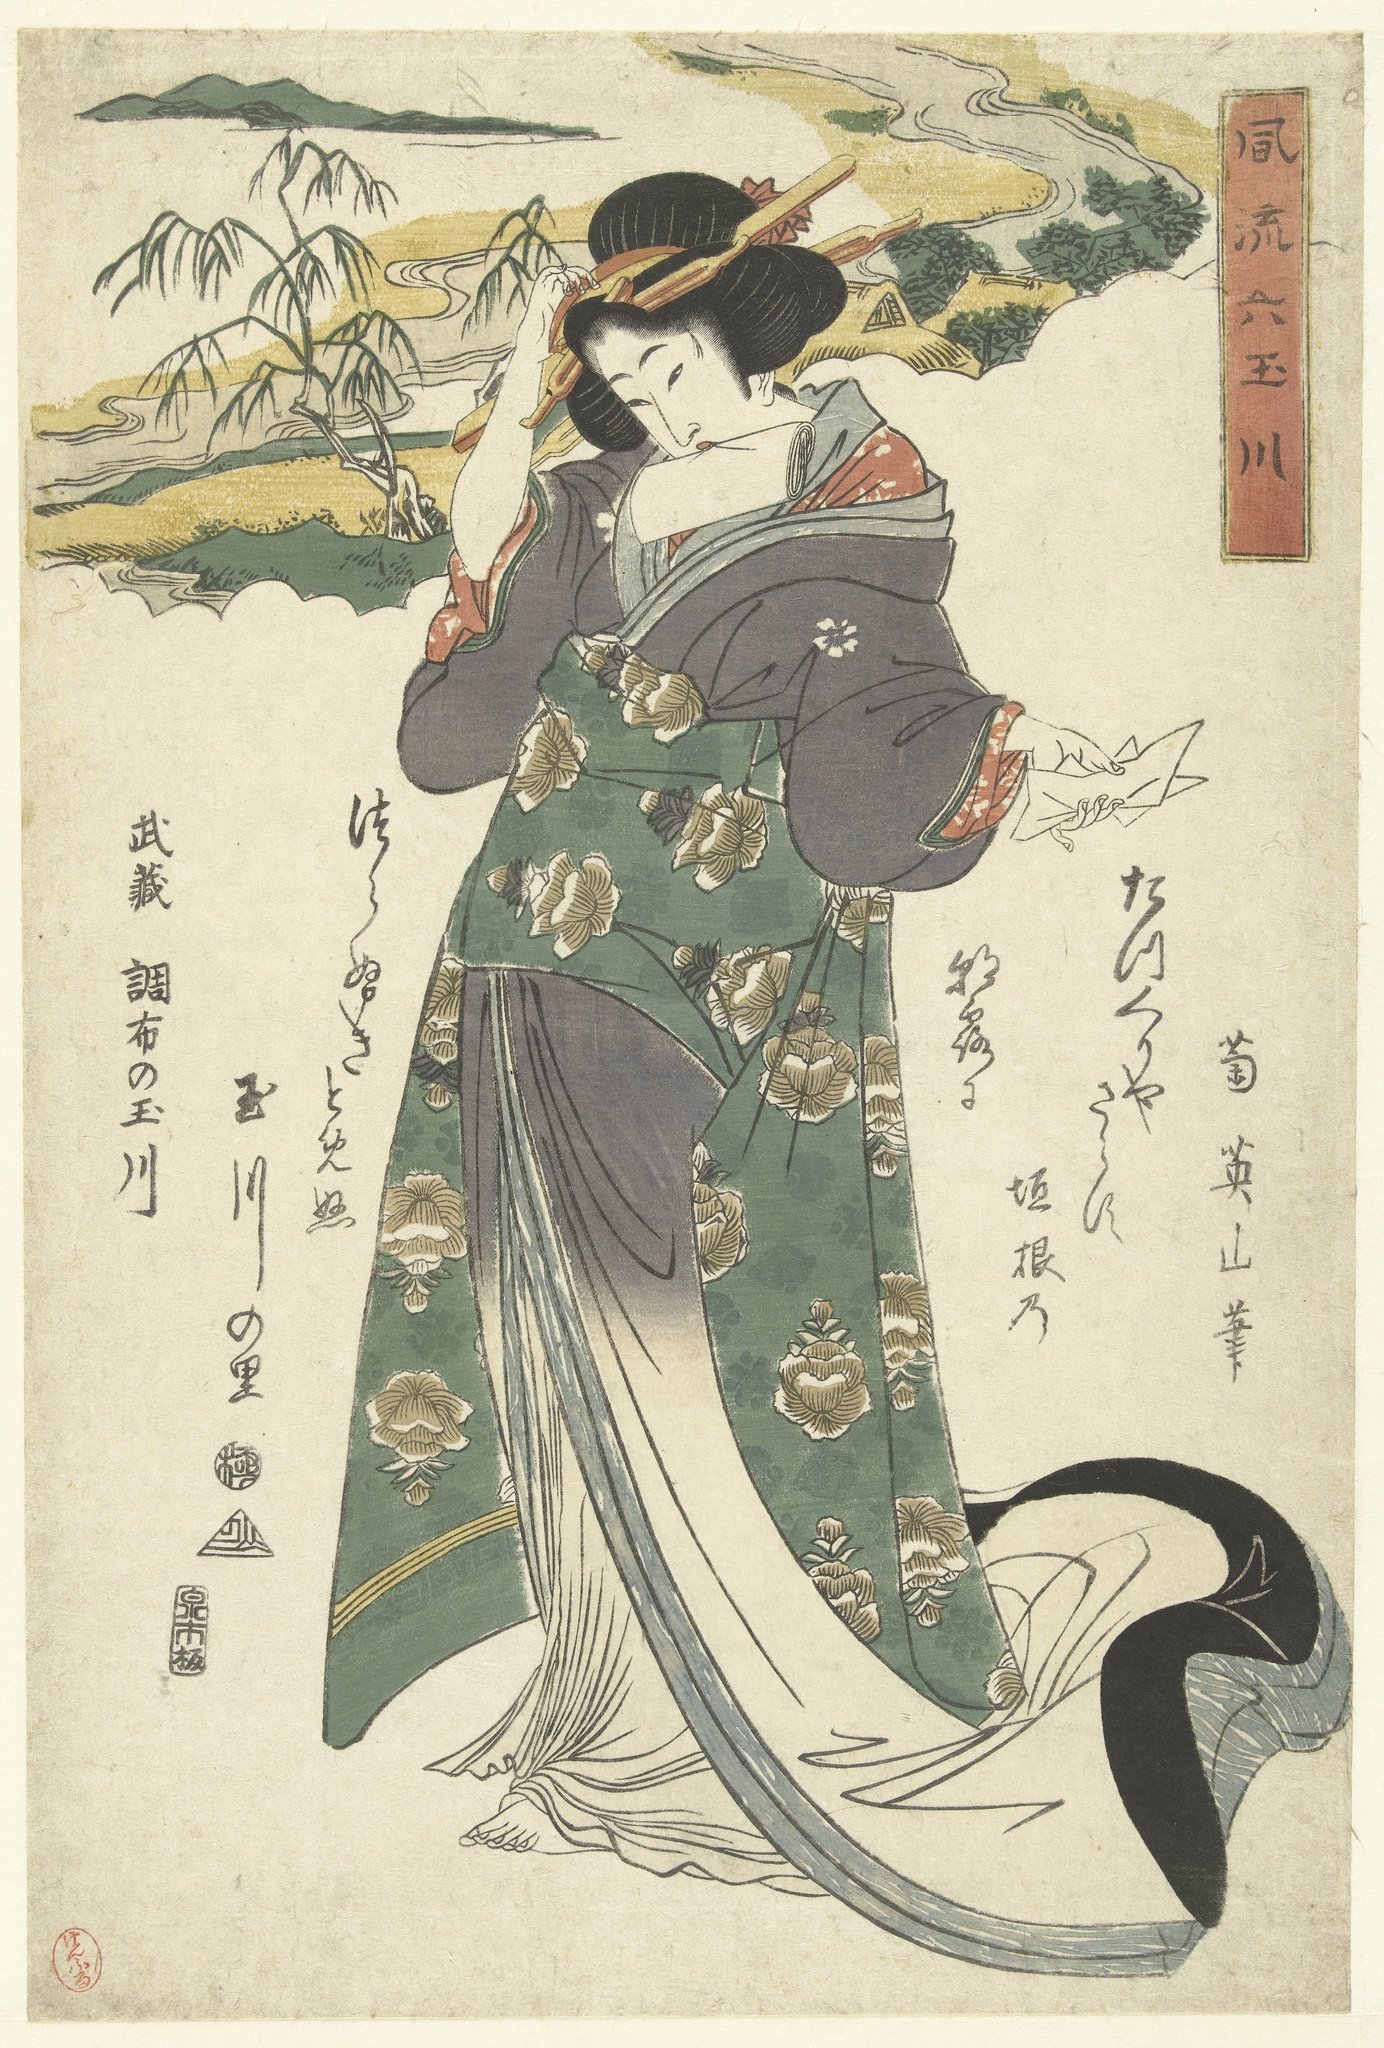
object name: print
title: De elegante zes Tama rivieren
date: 1812-1814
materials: paper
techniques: woodcut, nishiki e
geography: japan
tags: adult woman, river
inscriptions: collector's mark: ‘kenfuru’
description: Courtisane, de rechter hand bij het kapsel, in de linker hand een tissue, staand tegen witte achtergrond waarop gedicht, waarboven rivierlandschap.